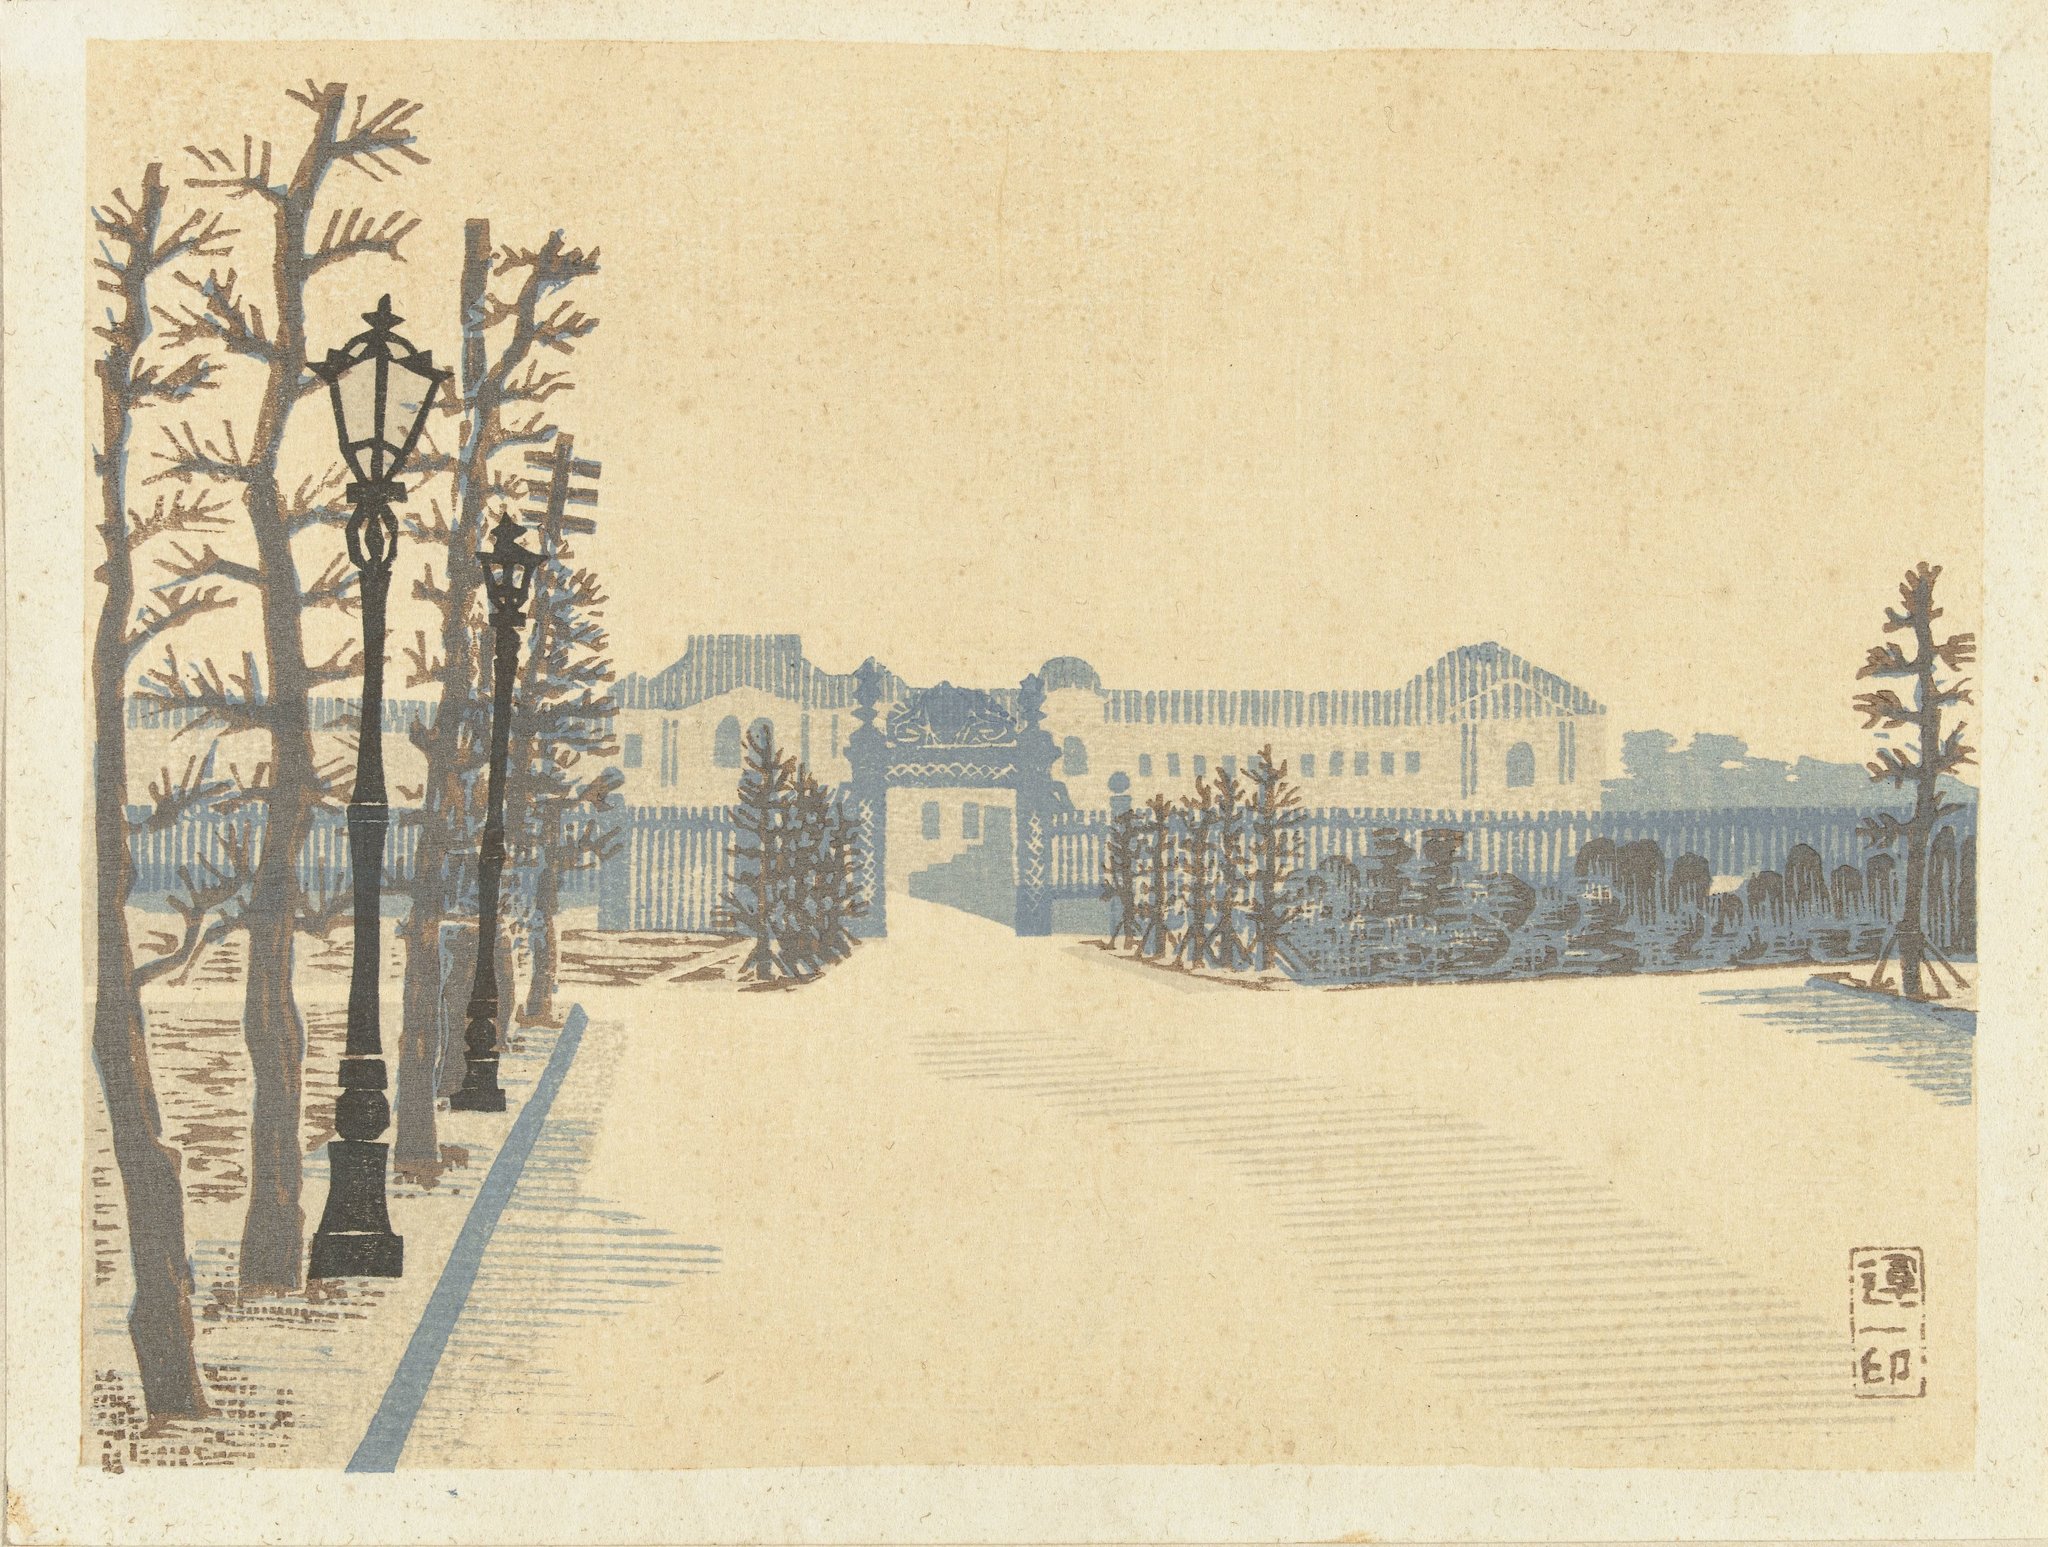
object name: print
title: Akasaka paleis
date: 1912-1945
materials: paper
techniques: woodcut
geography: tokyo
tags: palace, gate, entrance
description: Gezicht op brede laan met bomen en lantaarnpalen, leidend naar toegangspoort, waarachter paleis. In origineel passepartout met rechtsonder wit etiket waarop titel en naam van kunstenaar.